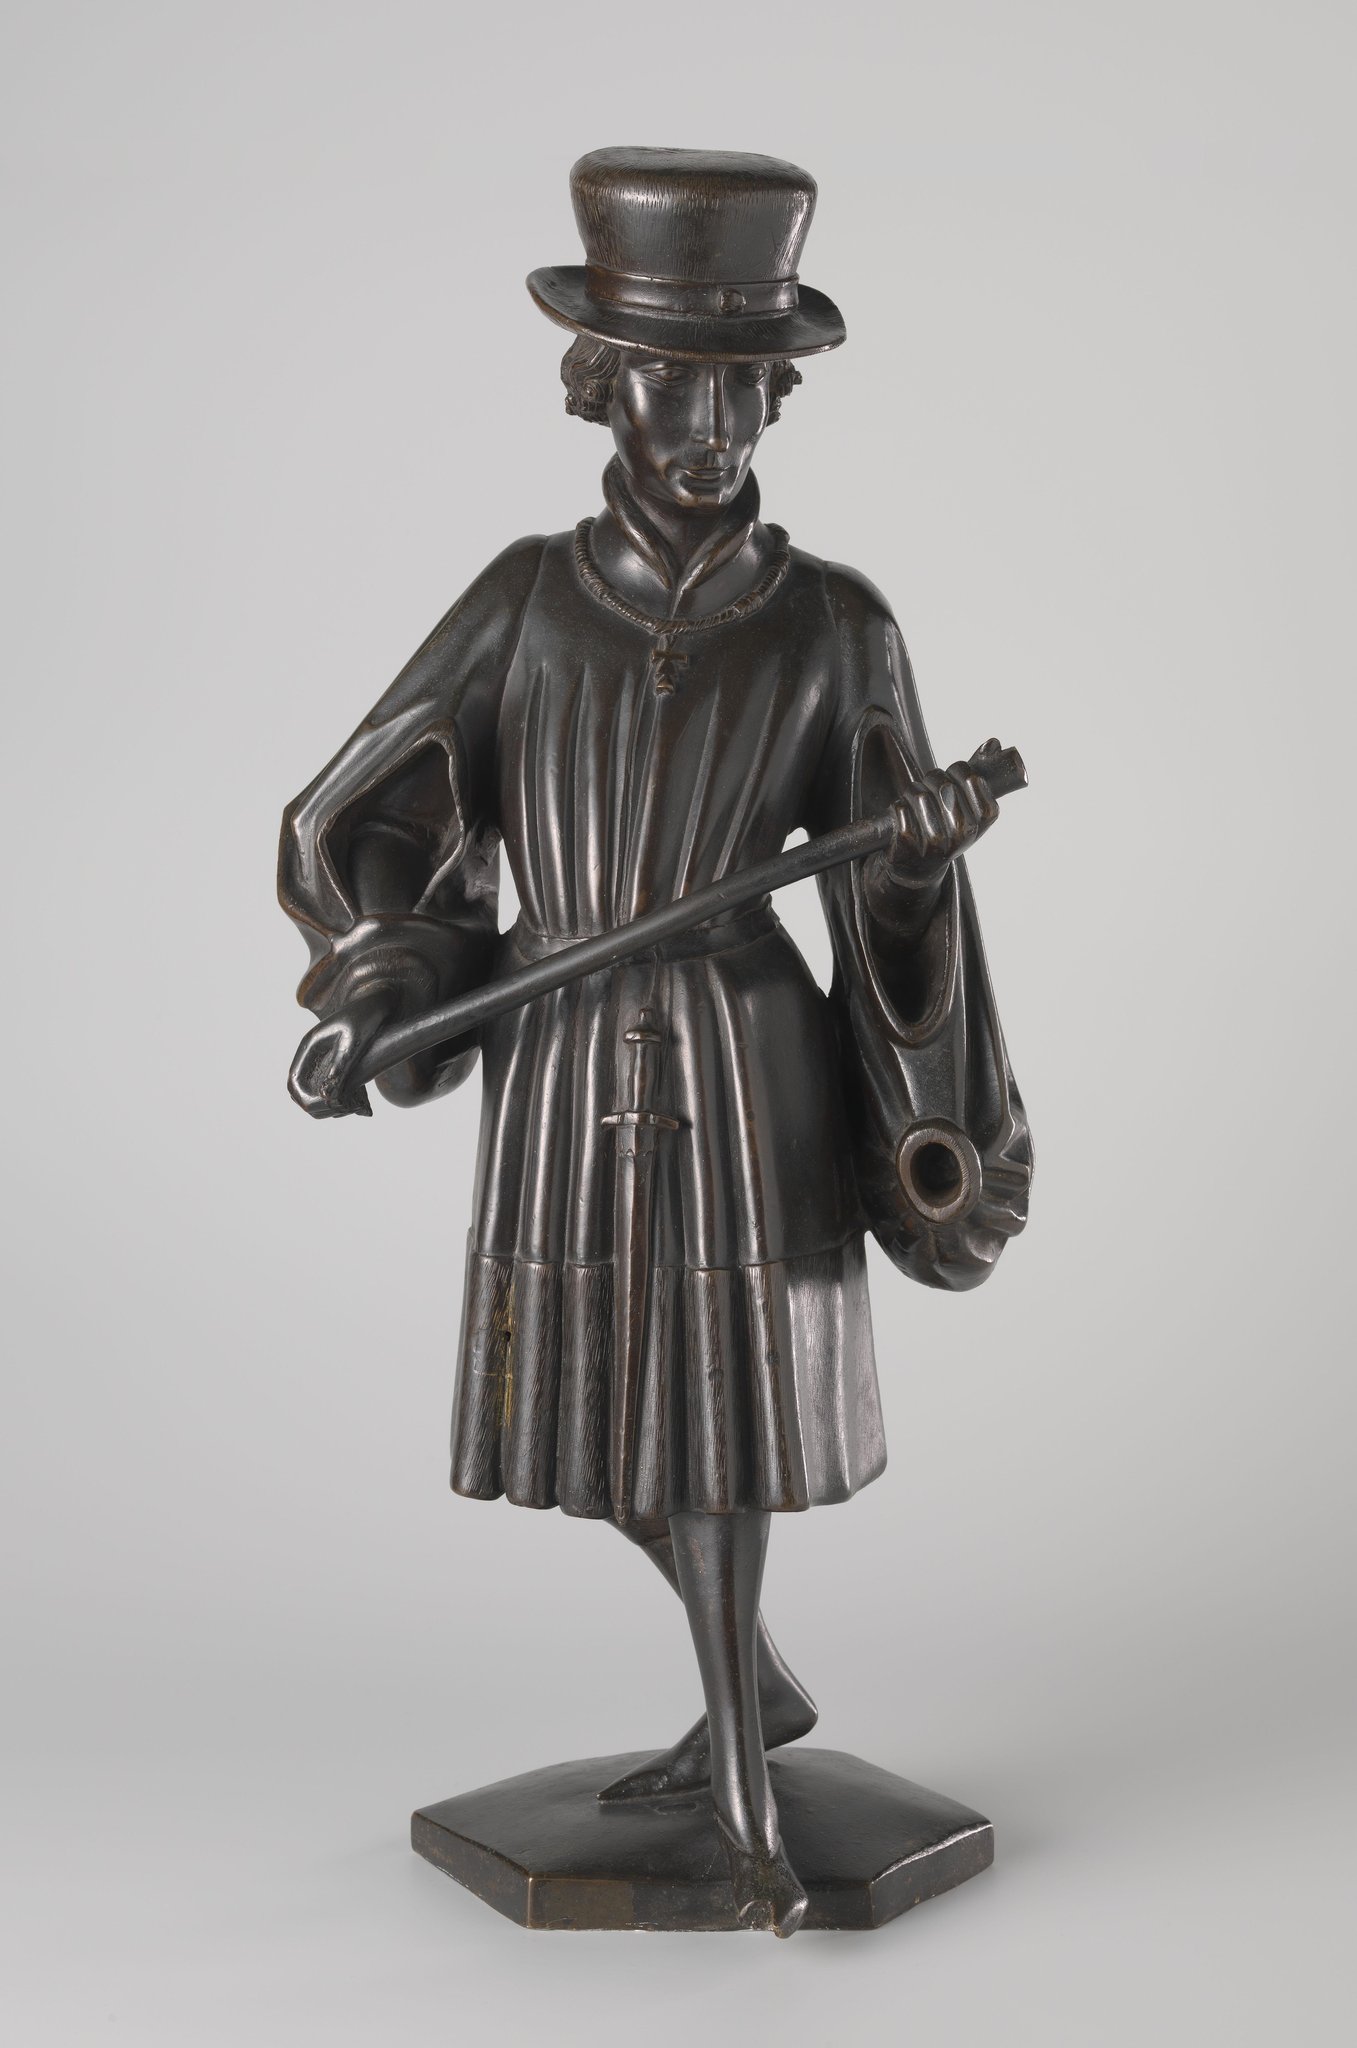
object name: tomb figure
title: Isabella van Bourbon & Pleurants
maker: renier van thienen (i)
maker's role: brazier, caster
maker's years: 1465-1498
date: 1475-1476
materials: bronze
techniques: casting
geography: brussels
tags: the hague, duke of bavaria albert i, 'pleurants', clothes, costume (+ men's clothes), nobility and patriciate; chivalry, knighthood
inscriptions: number, on the back, at the top, in modern white paint: ‘3’, inscription, on the back, at the bottom, incised after casting and finishing: indistinguishable location mark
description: Mary of Burgundy had a mausoleum erected for her late mother, Isabella of Bourbon. Only the gisant (tomb effigy) of Isabella and 10 of the 24 figures originally surrounding the tomb have been preserved. These pleurants (weepers) represent five generations of grieving forebears. While the tomb commemorated Isabella, it mainly served to advertise Mary’s noble lineage. She was the sole remaining heir of the Dukes of Burgundy and therefore a highly desirable consort. A year after the monument was completed, she married Maximilian of Habsburg, whereby the Burgundian Netherlands became part of the vast Holy Roman Empire.